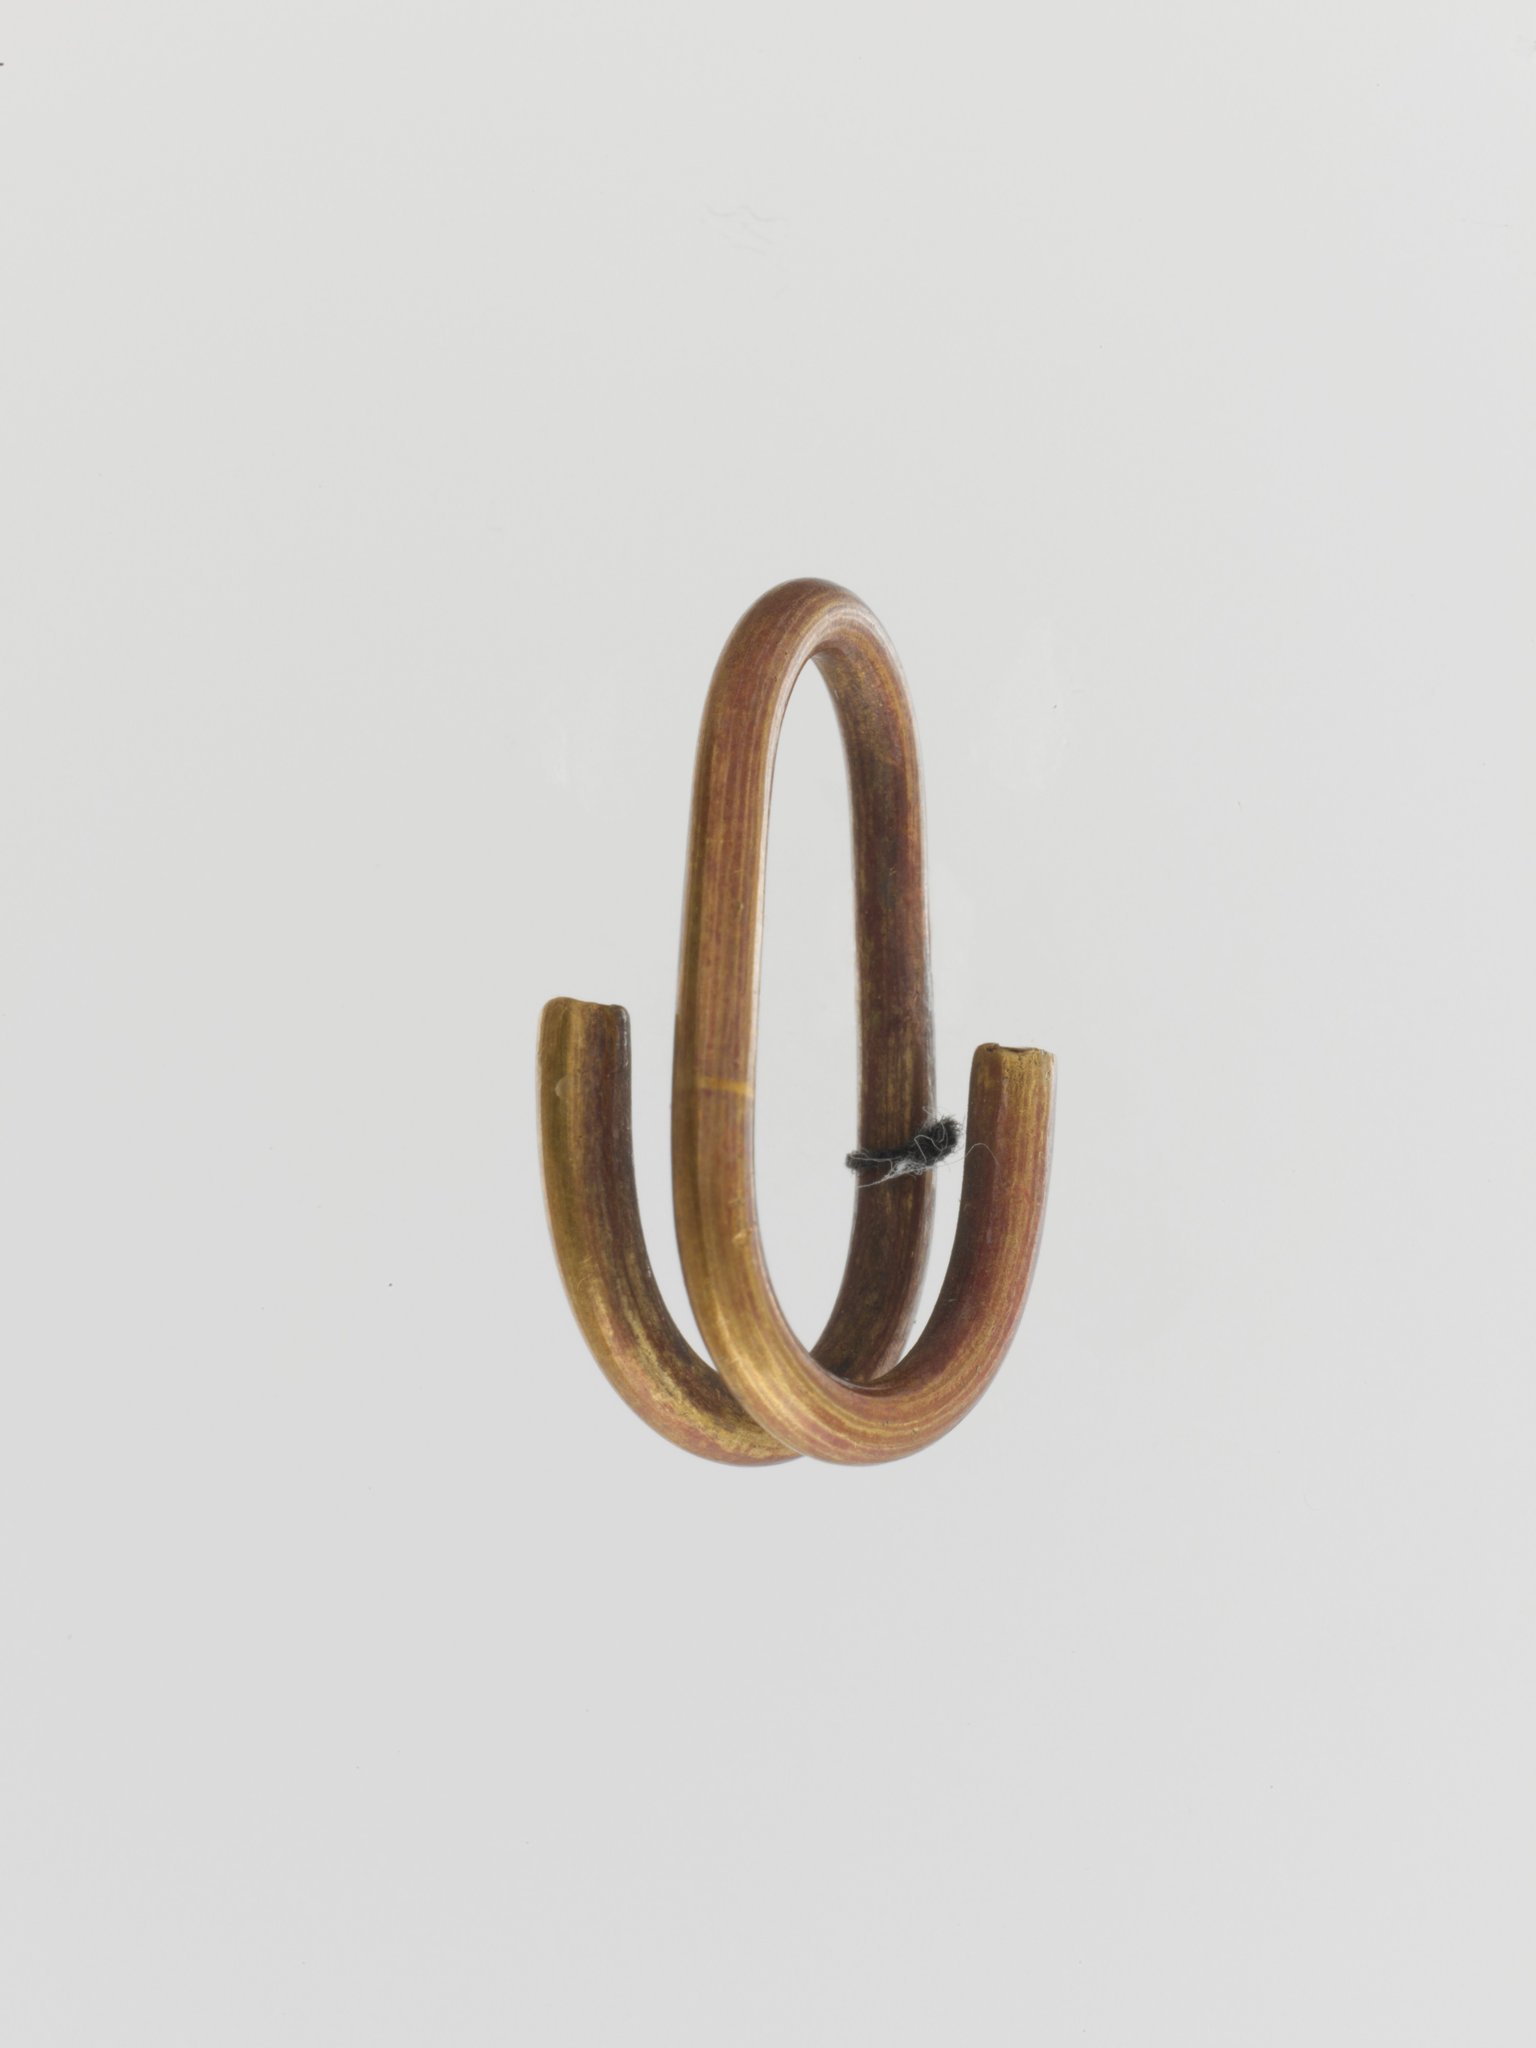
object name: earring or spiral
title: Gold spiral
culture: cypriot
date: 1600-1100 BCE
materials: gold